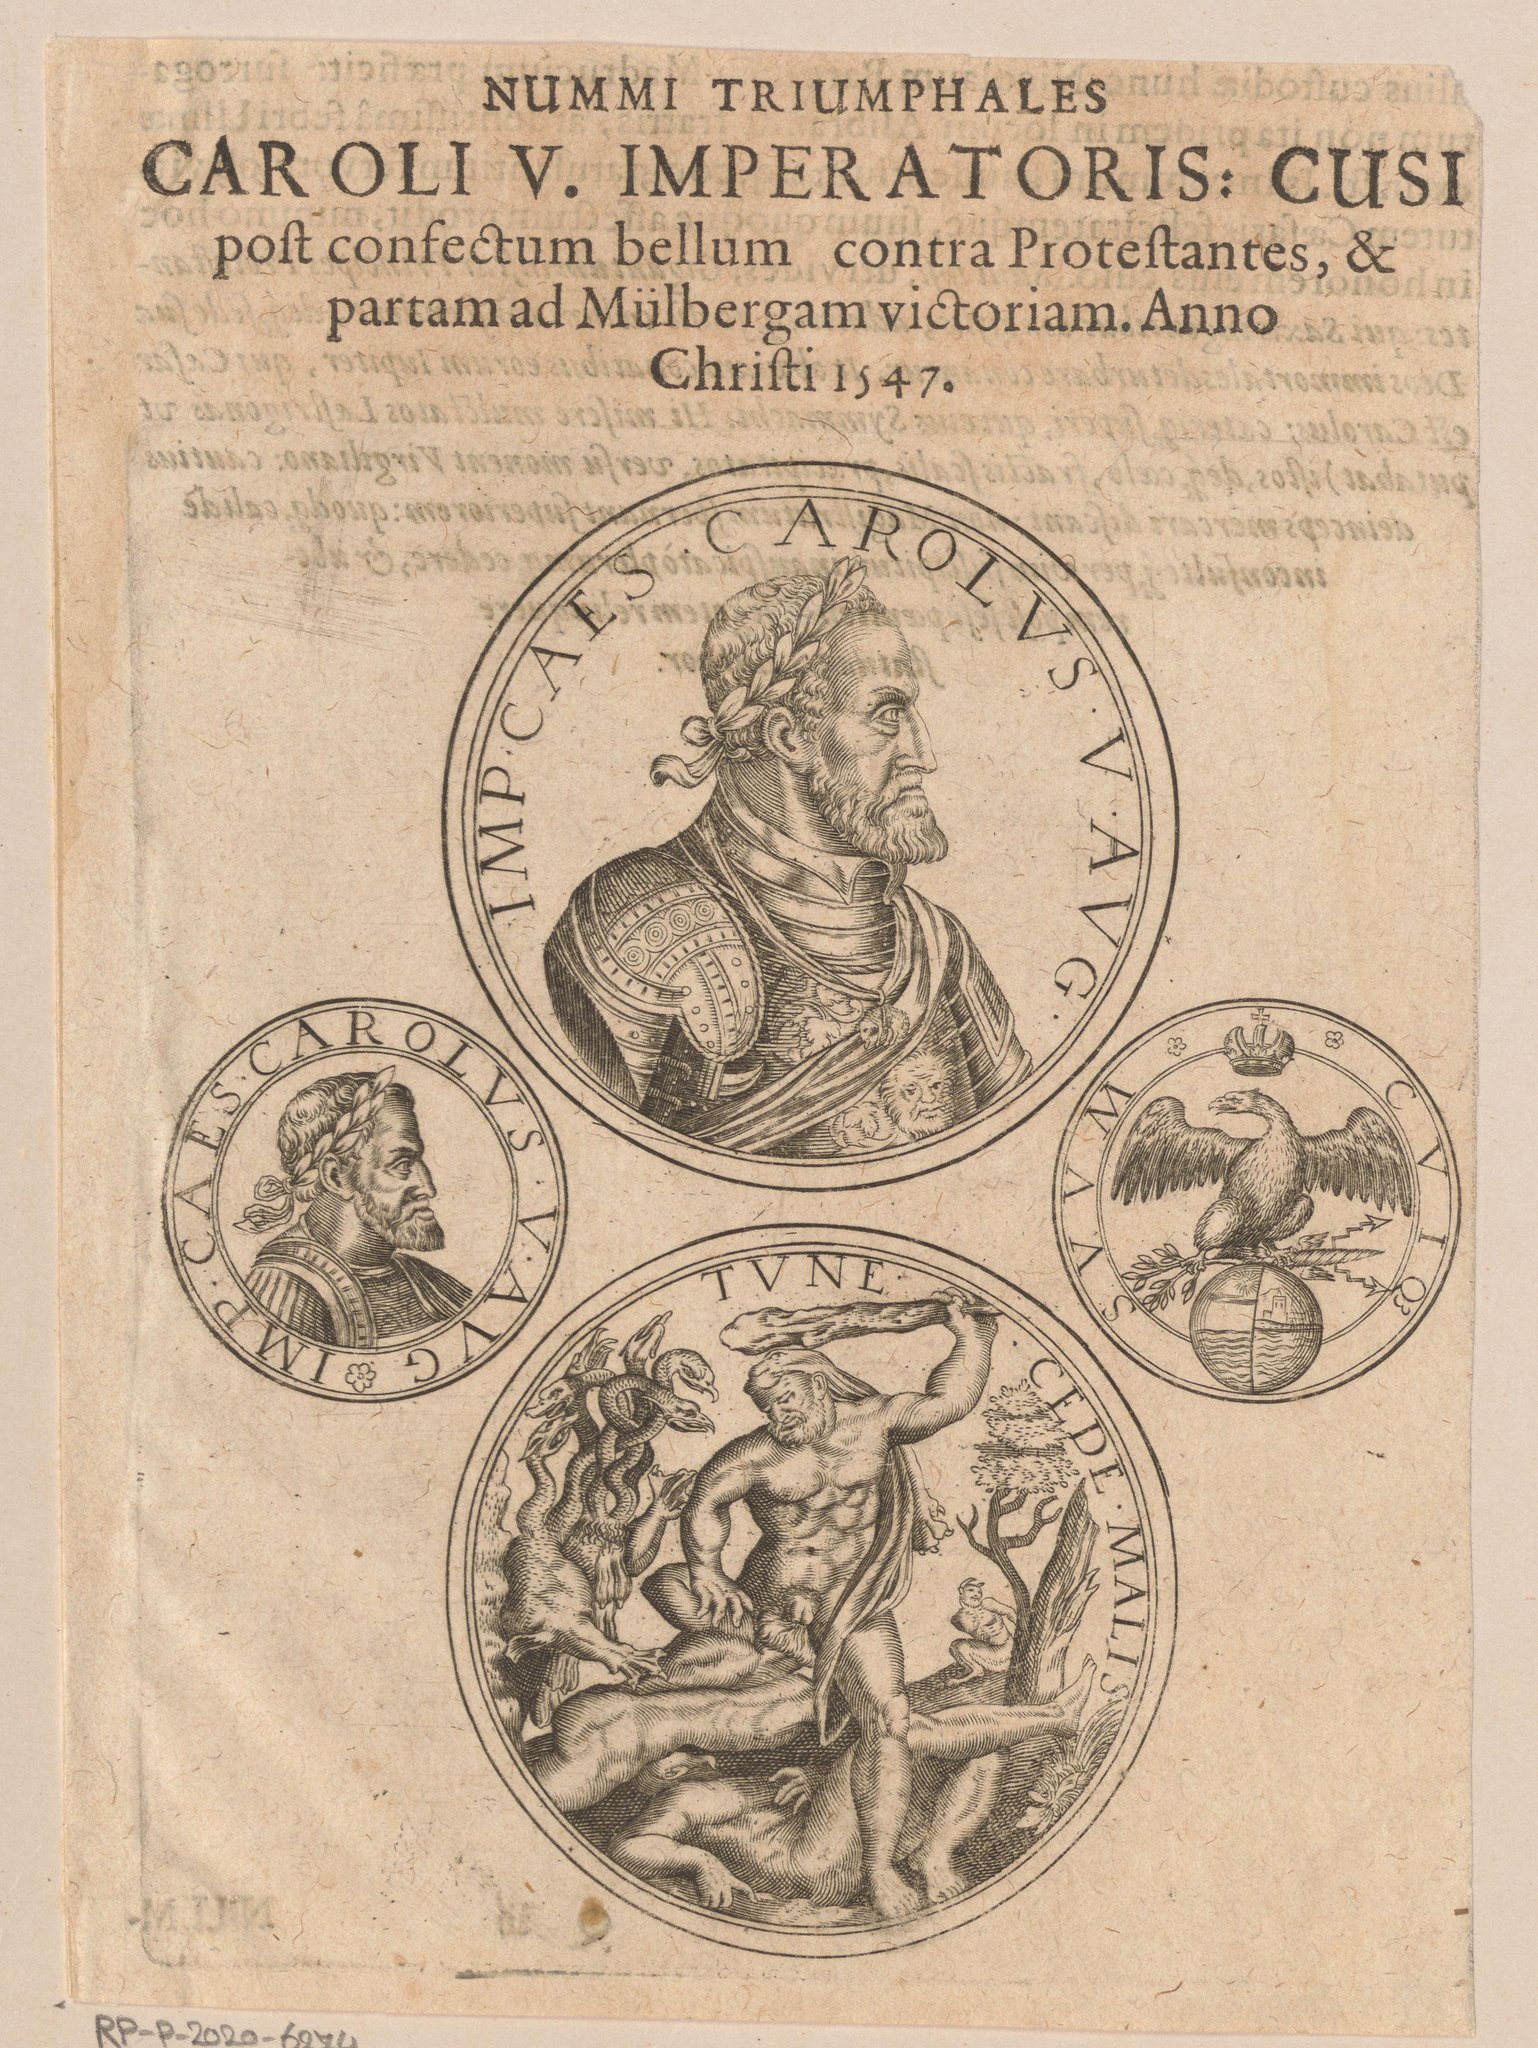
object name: book illustration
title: Medaille met het portret van keizer Karel V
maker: Anonymous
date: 1620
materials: paper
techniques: engraving, letterpress printing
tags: ghent, charles v (holy roman emperor and king of spain), (2) the hydra of lerna is killed by hercules, historical persons, king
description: Prent uit: Luck, Johann Jacob. Sylloge numismatum elegantiorum quae diuersi (...). S.l.s.n.,1620, p. 84.